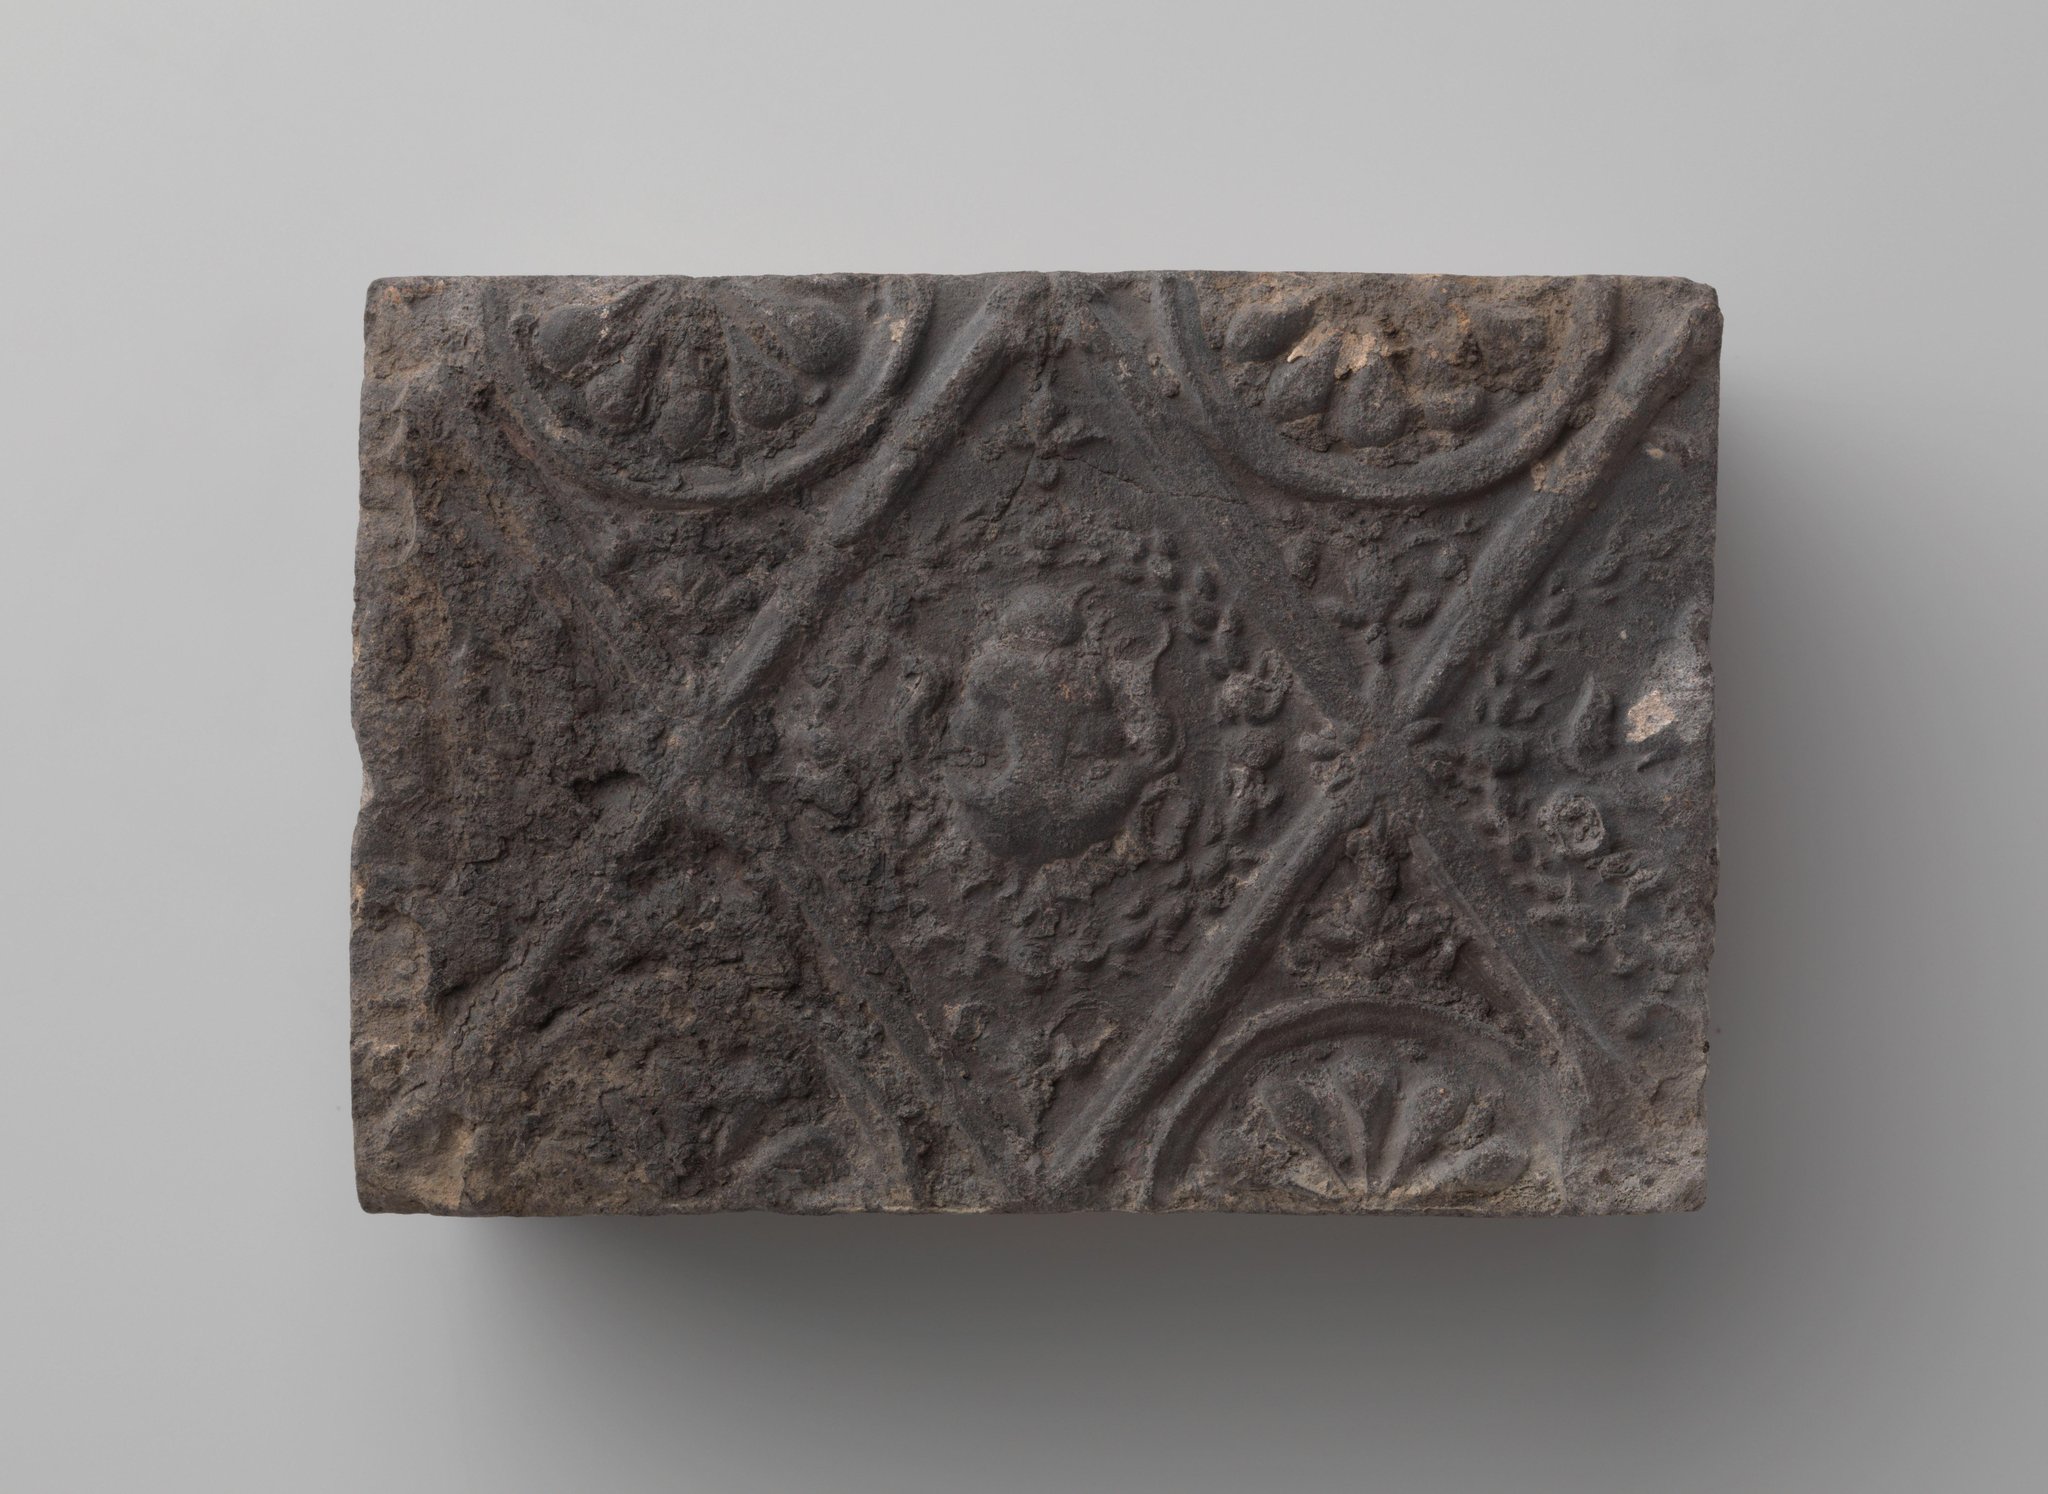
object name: hearthstone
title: Haardsteen met leeuwenkop in geprofileerde ruit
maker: Anonymous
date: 1575-1625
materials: earthenware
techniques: printing, firing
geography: southern netherlands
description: Haardsteen met voorstelling van leeuwenkop in lauwerkrans, geplaatst in geprofileerde ruit, welk motief zich in de halve ruiten aan de zijkanten herhaald. De hale ruiten aan de boven- en onderkant zijn opgevuld met halve medaillons met stermotief.